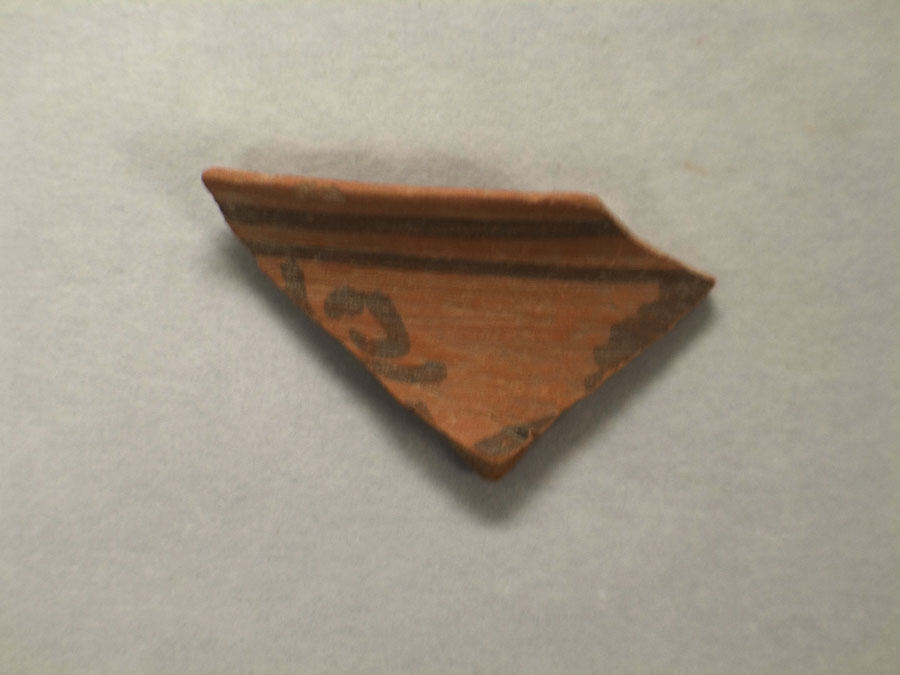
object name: shard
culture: pakistani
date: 301-500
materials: terracotta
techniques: painting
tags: gandhara